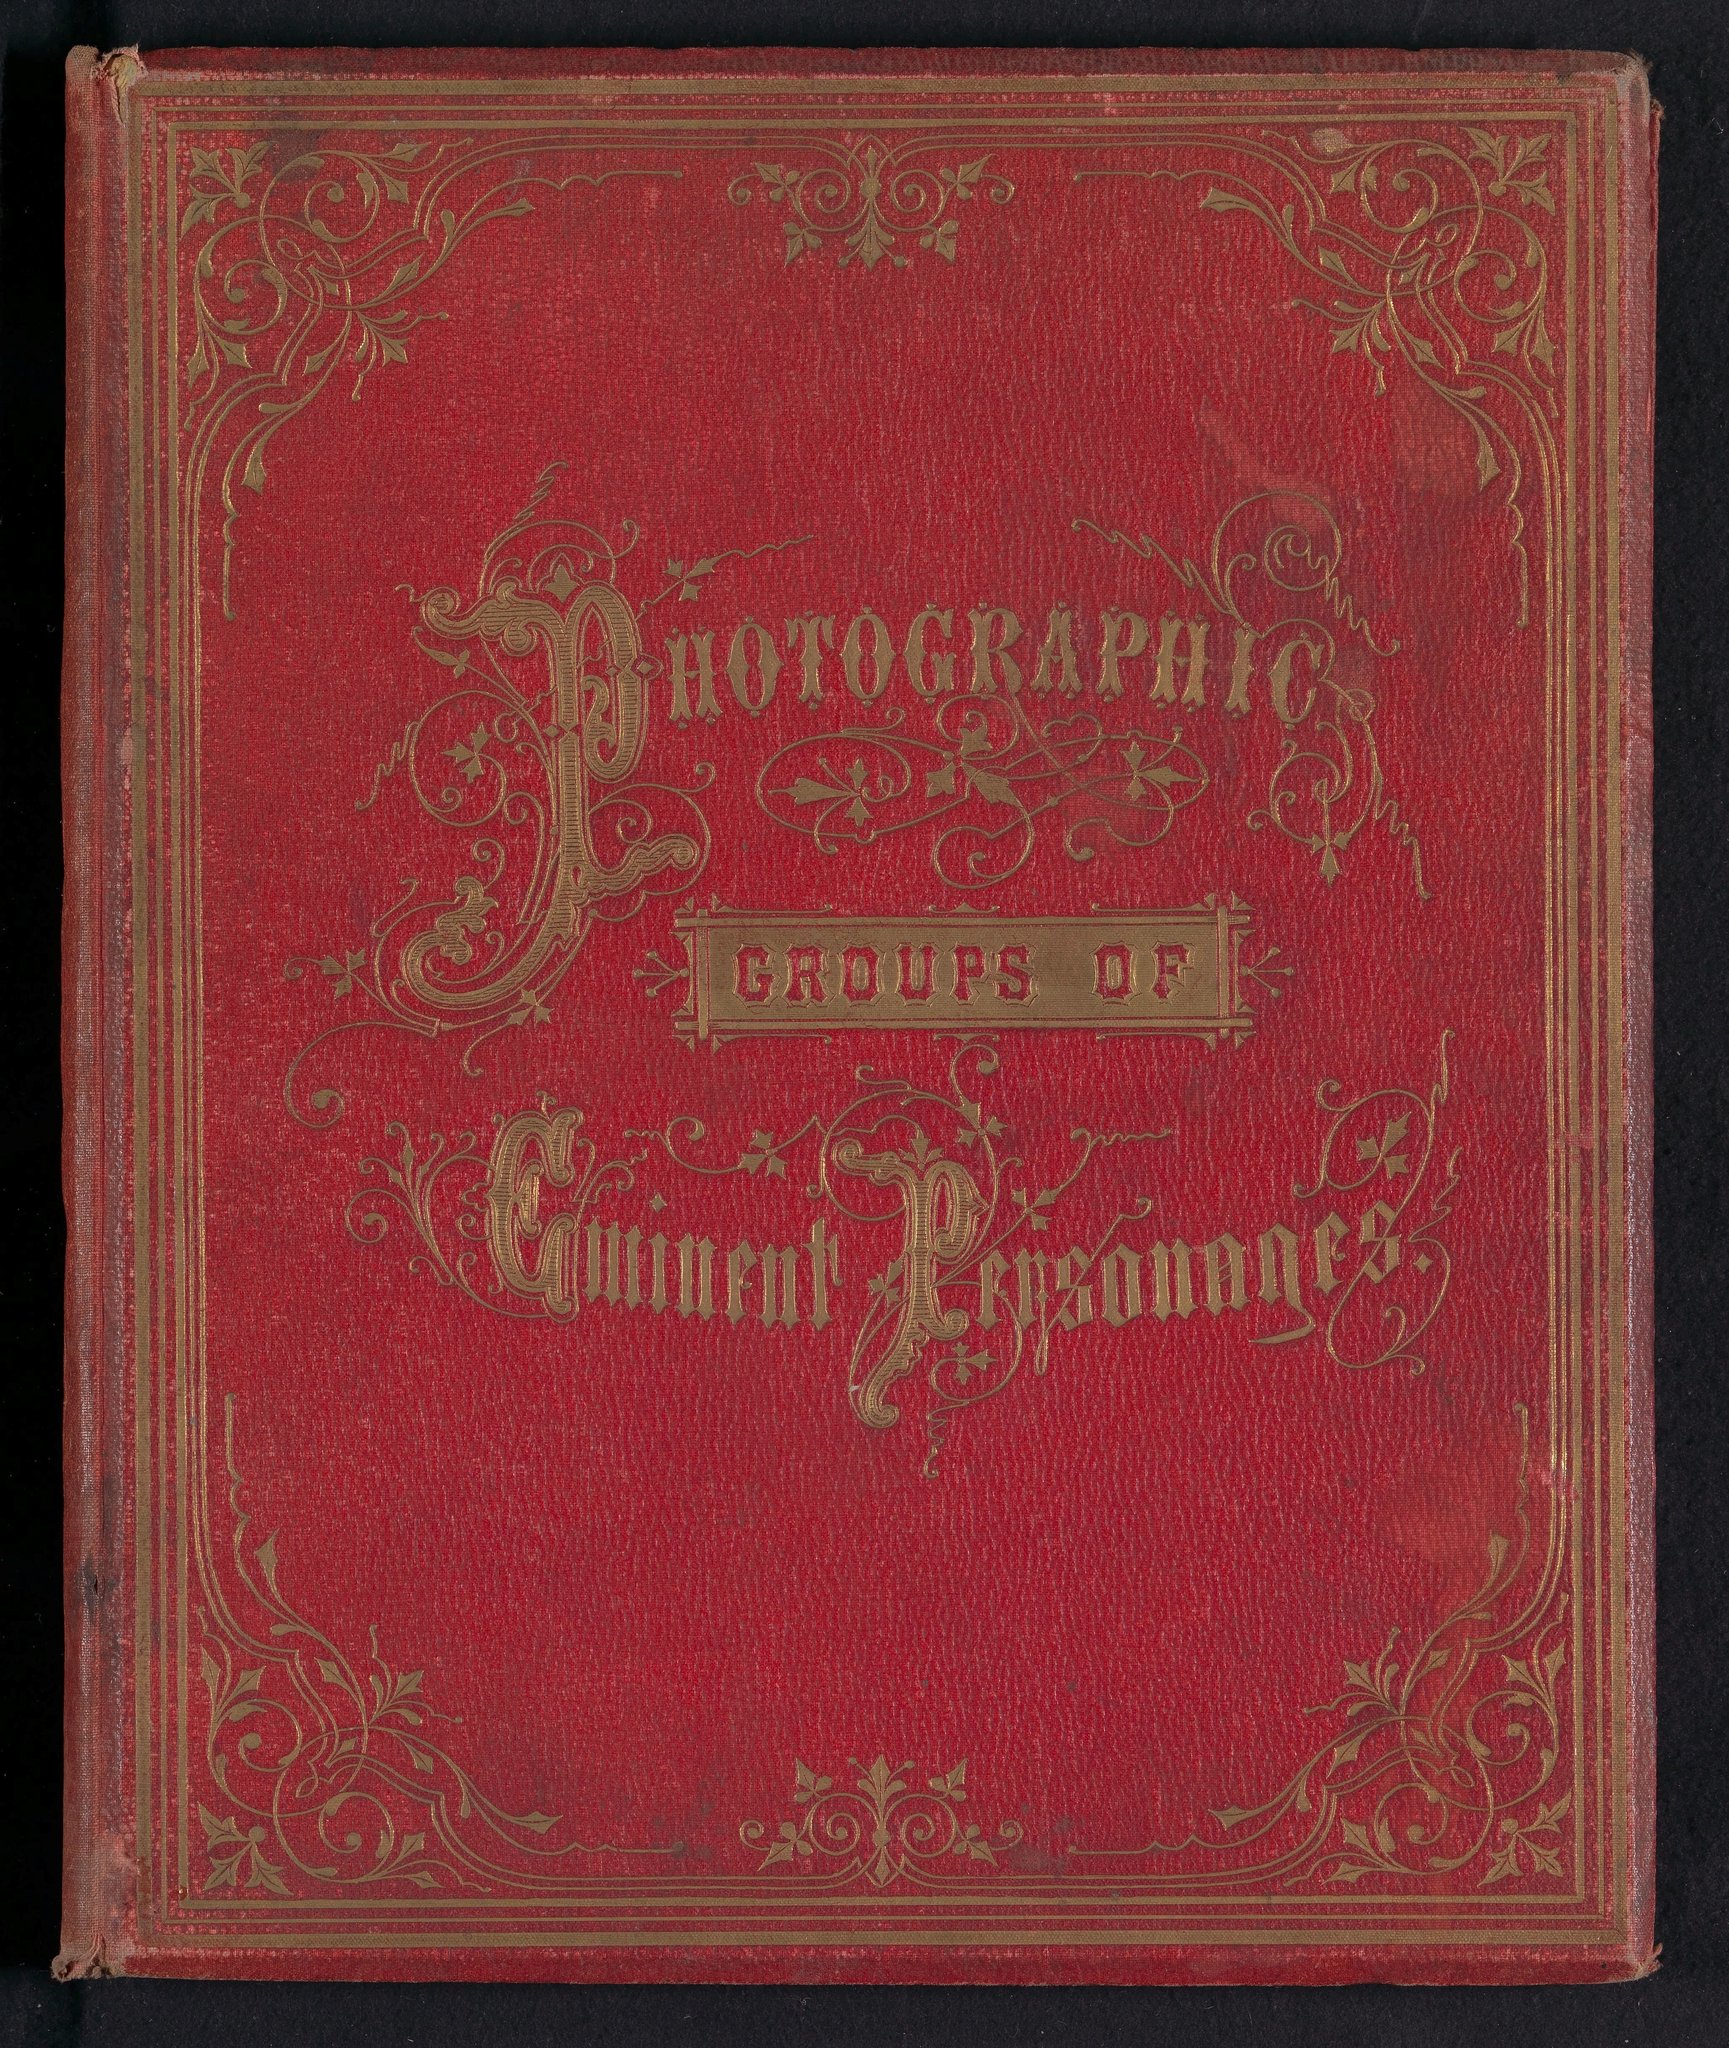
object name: book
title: Photographic groups of eminent personages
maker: Anonymous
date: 1883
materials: cardboard, linen, paper, photographic support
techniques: albumen print, printing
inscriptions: name: ‘ex libris SFJ’